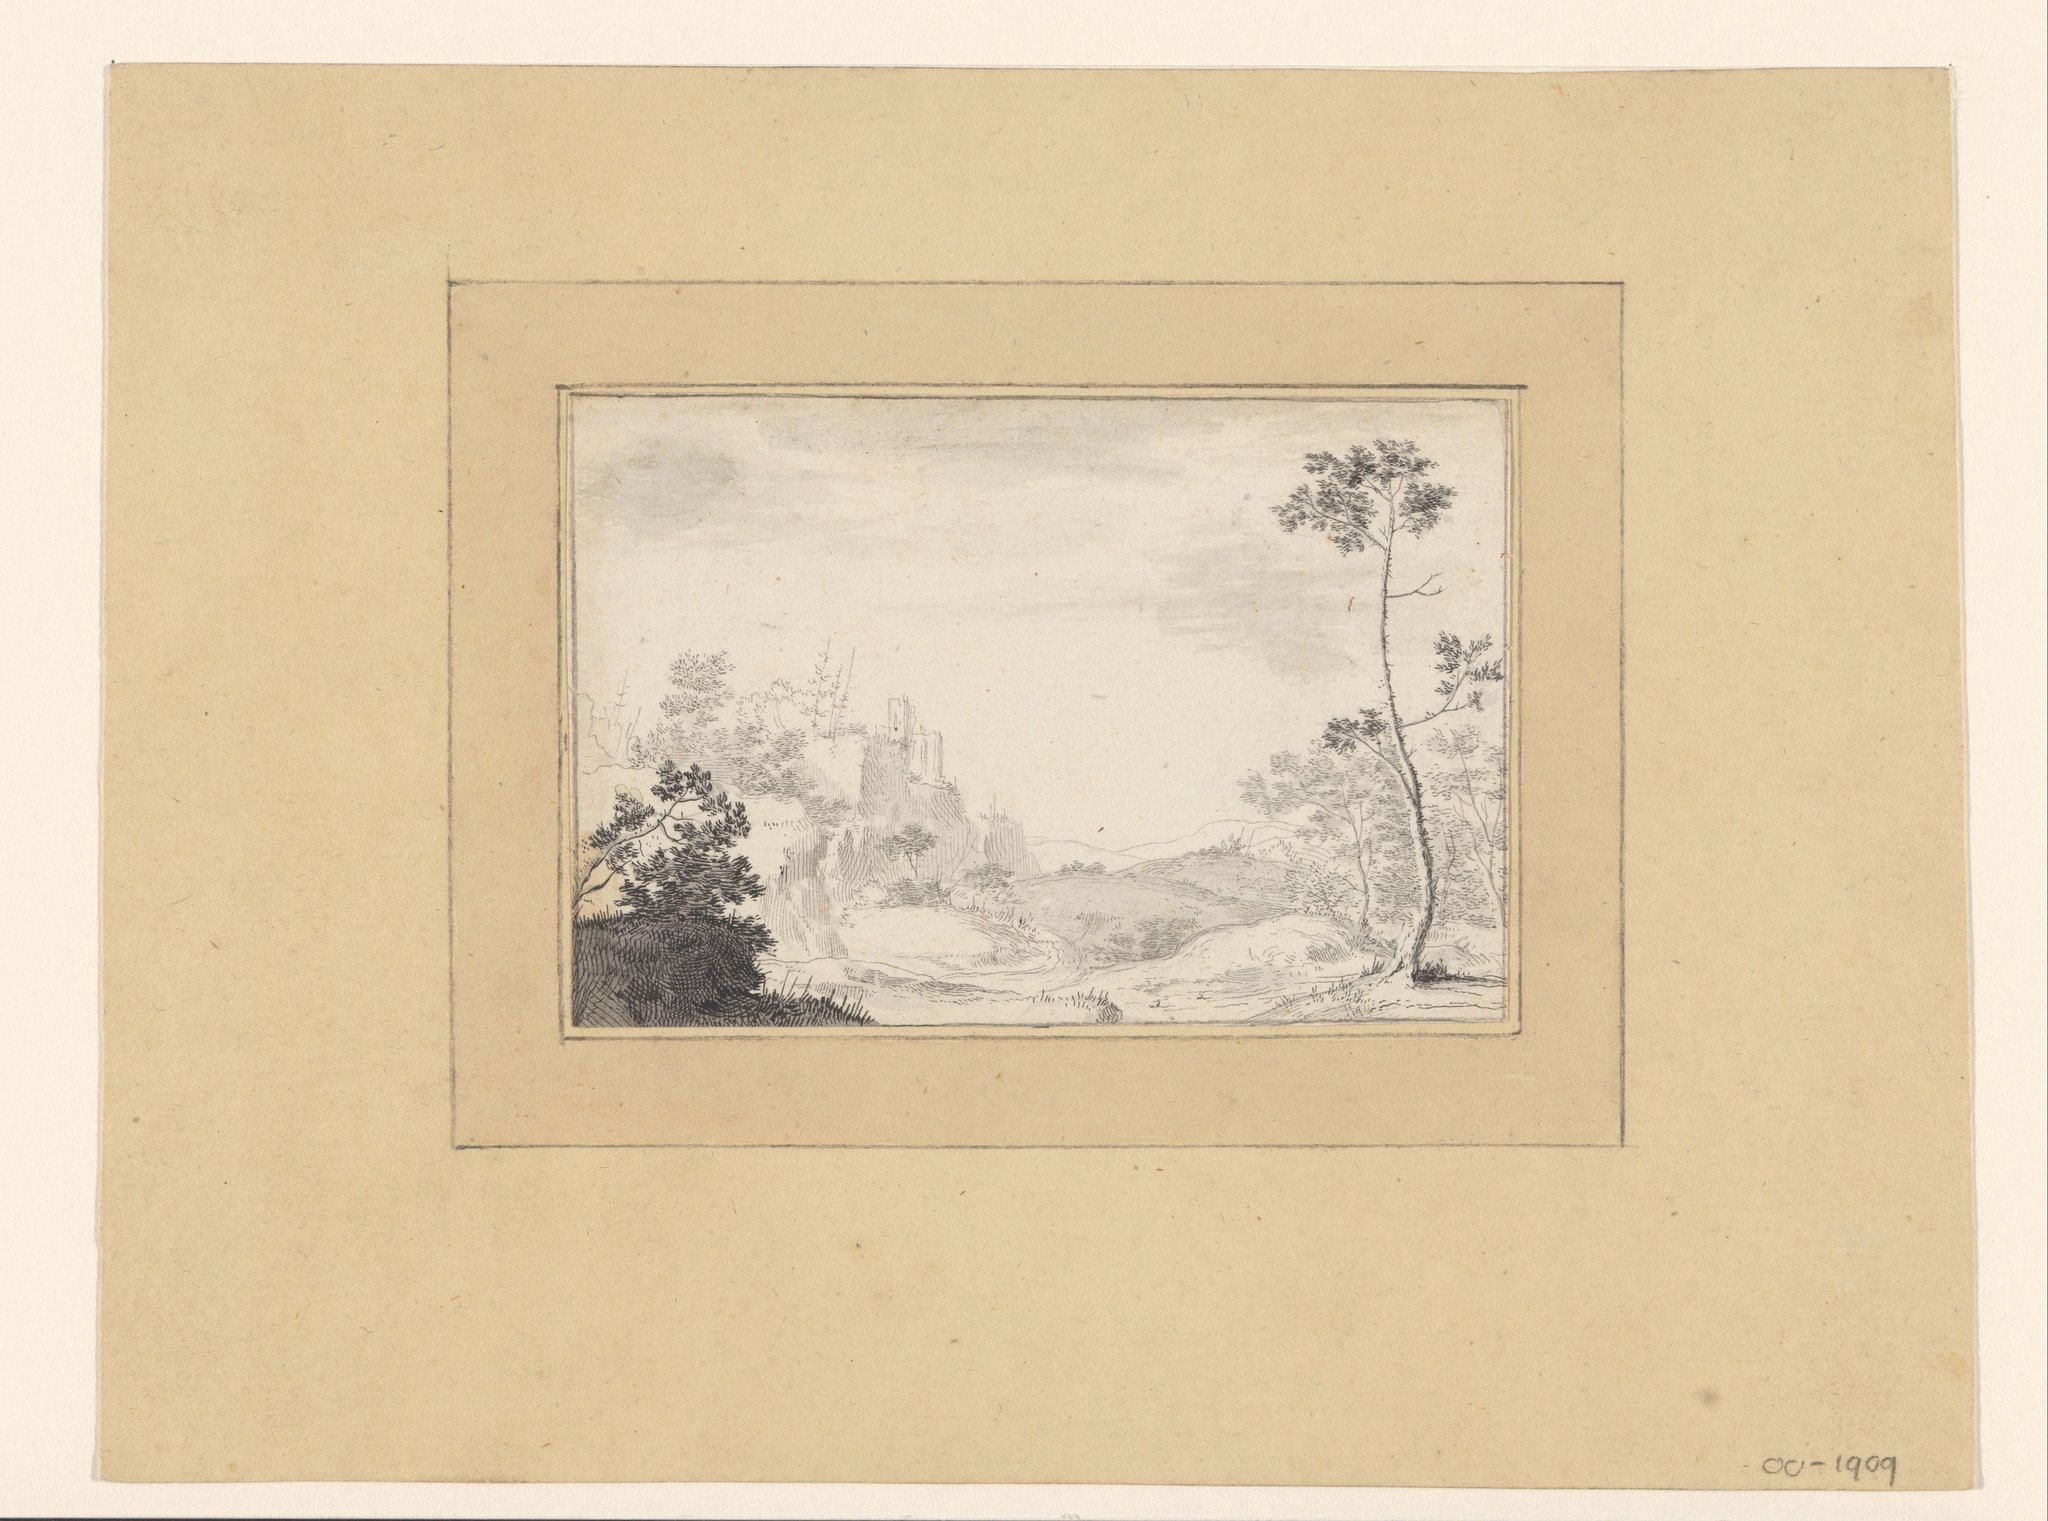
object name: drawing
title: Heuvellandschap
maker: Anonymous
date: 1700-1800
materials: ink, paper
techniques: brush, pen